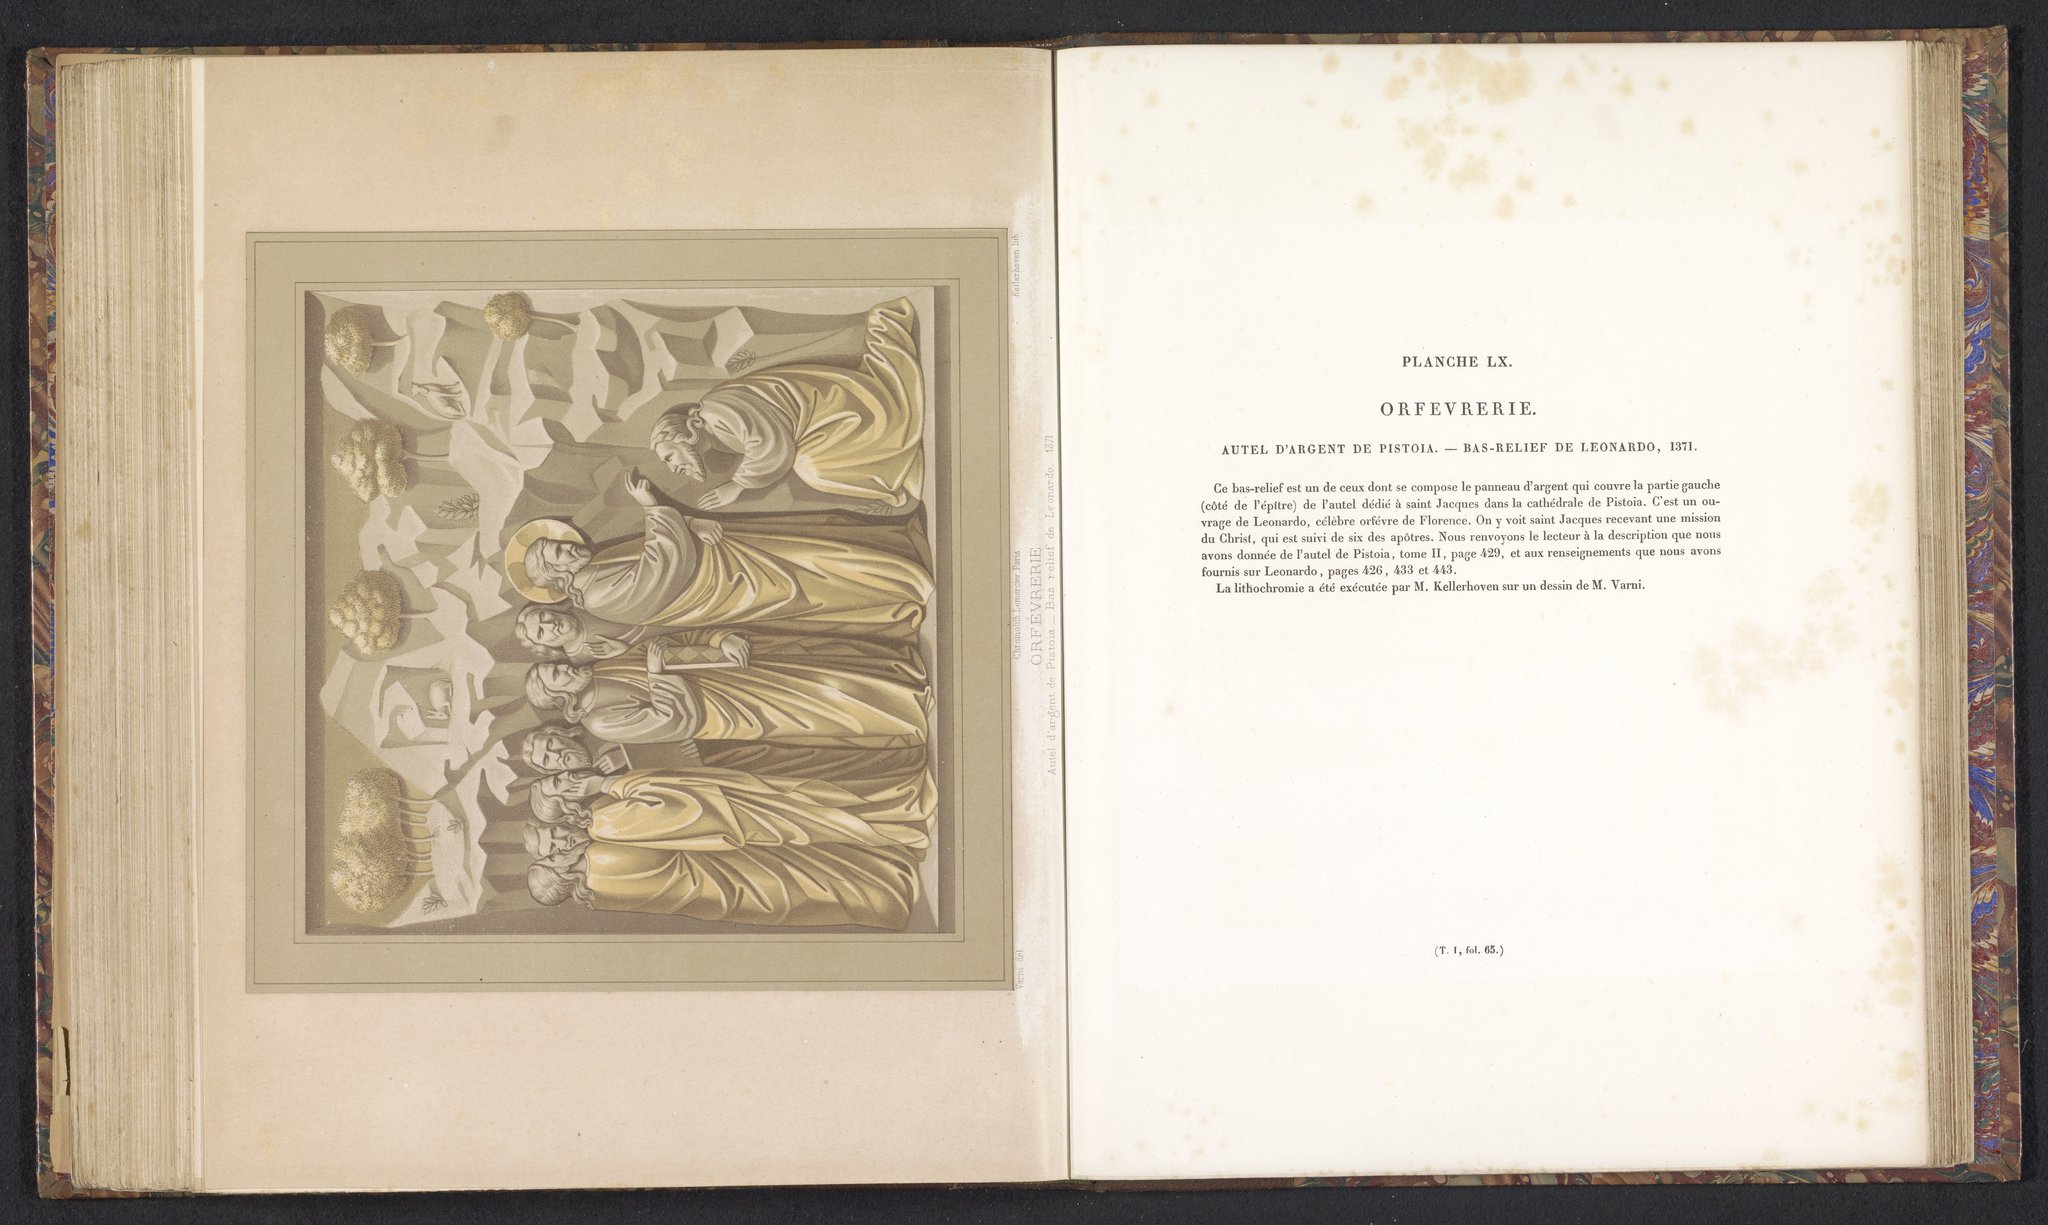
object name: print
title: Orfévrerie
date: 1859-1864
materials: paper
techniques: chromolithography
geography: paris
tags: altar, calling of james and john, the sons of zebedee (matthew 4:21-22; mark 1:19-20; luke 5:10-11), sculpture (+ relief ~ sculpture)